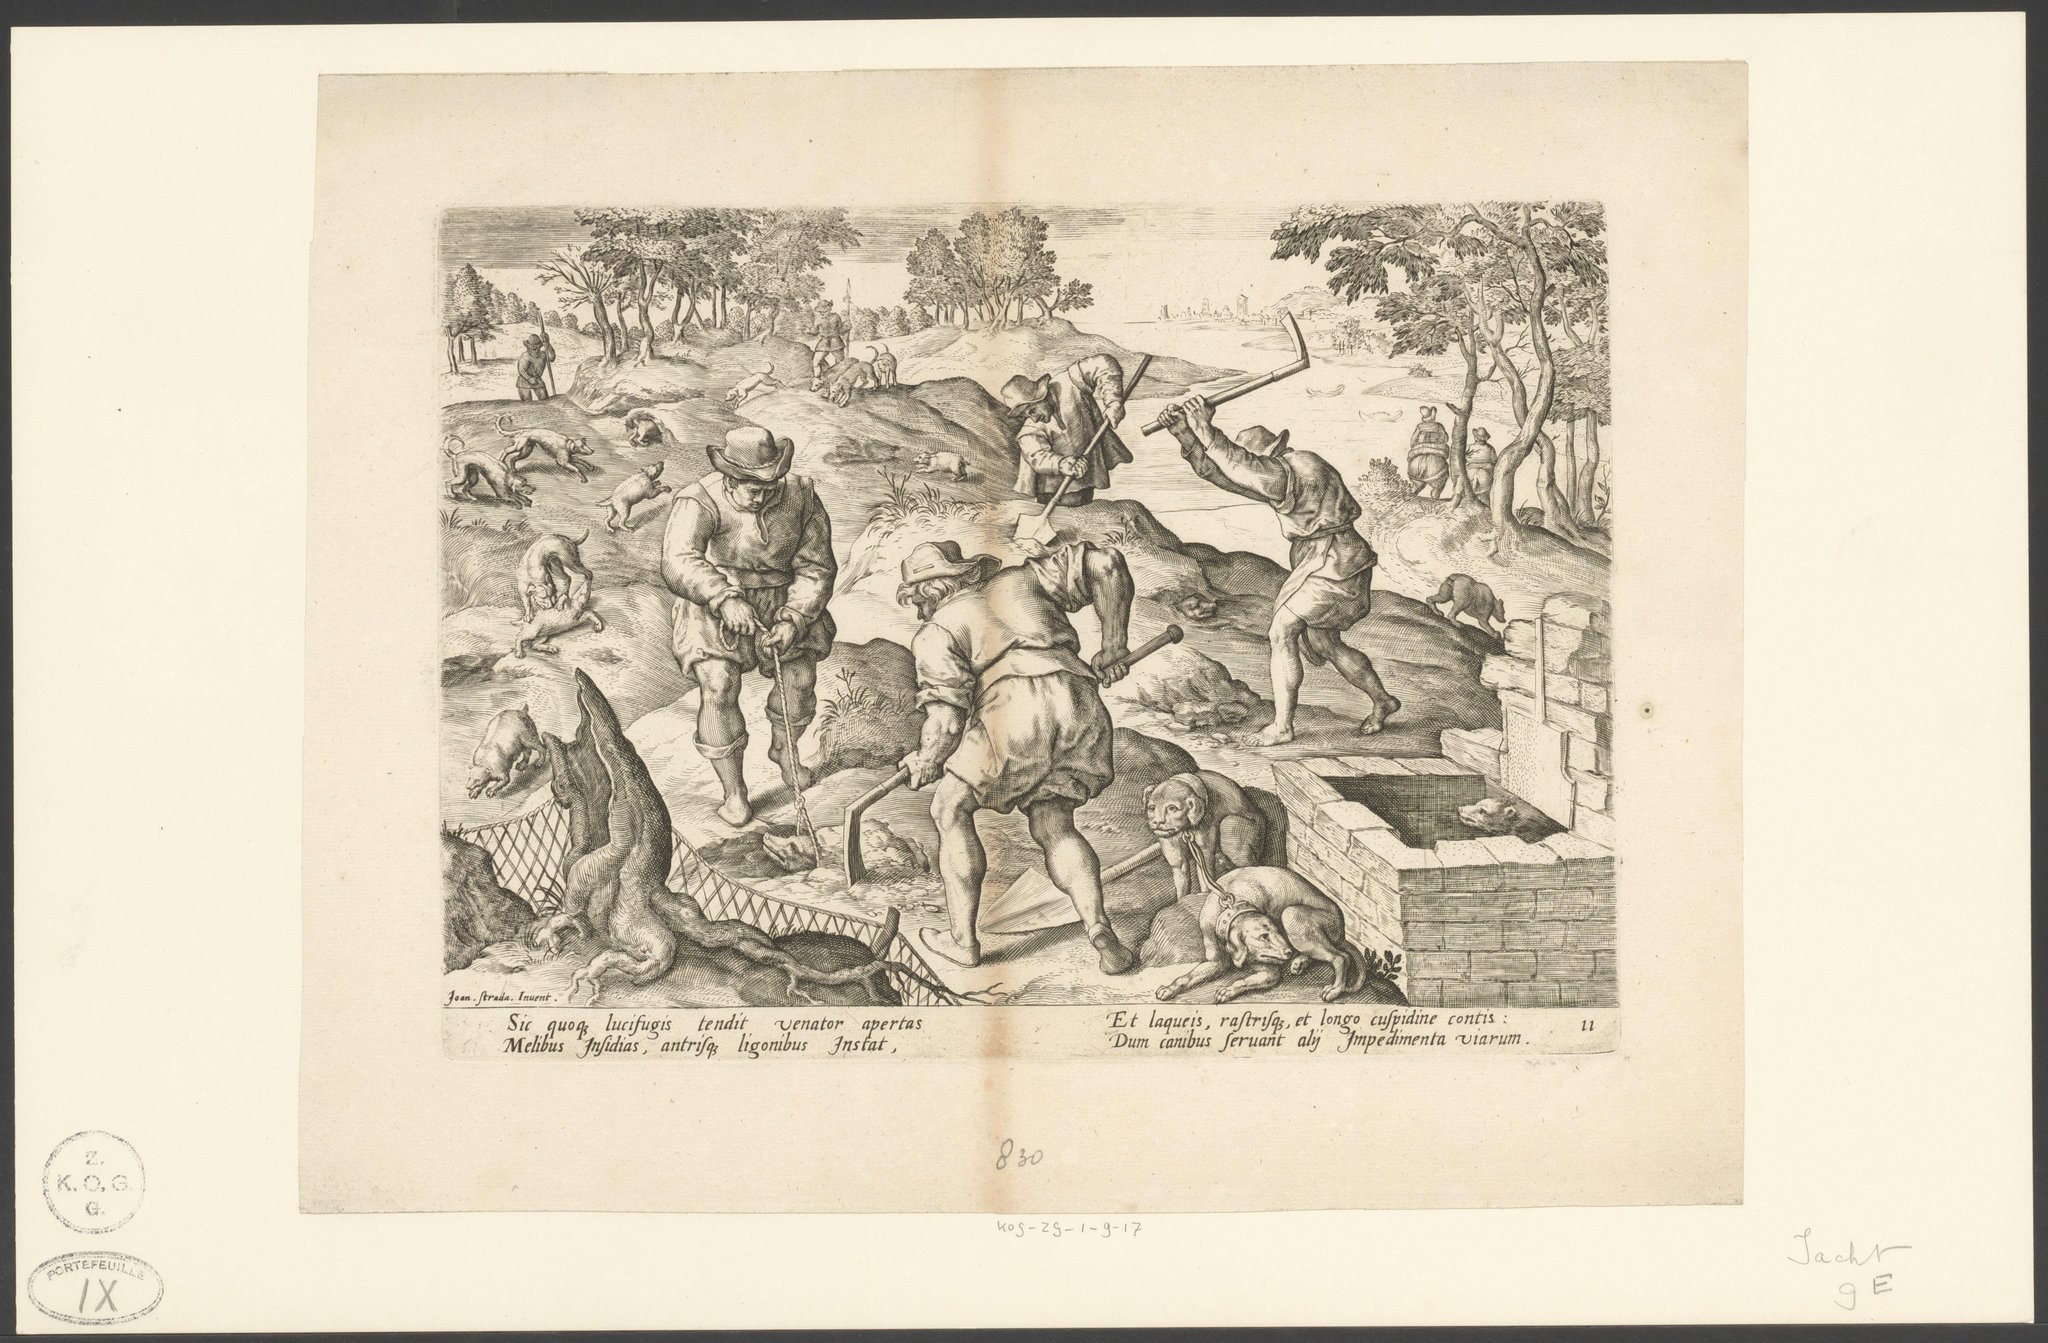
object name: print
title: Jachttaferelen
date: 1567-1601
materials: paper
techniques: engraving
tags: hunters hunting (n.b.: in 1988-1990 this notation denoted the concept of 43c11421 'hunters resting during the hunt'), beasts of prey, predatory animals: badger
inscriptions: stamp, collector's mark: Lugt 1641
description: Mannen jagen en graven dassen uit en vangen deze met netten. Ze worden geholpen door enkele honden. Onder de voorstelling een vierregelig vers in het Latijn. Rechtsonder genummerd: 11. Onderwerpsrubrieken binnen de Atlas Zeden en Gewoonten: Handel, nijverheid en verkeer, jacht.